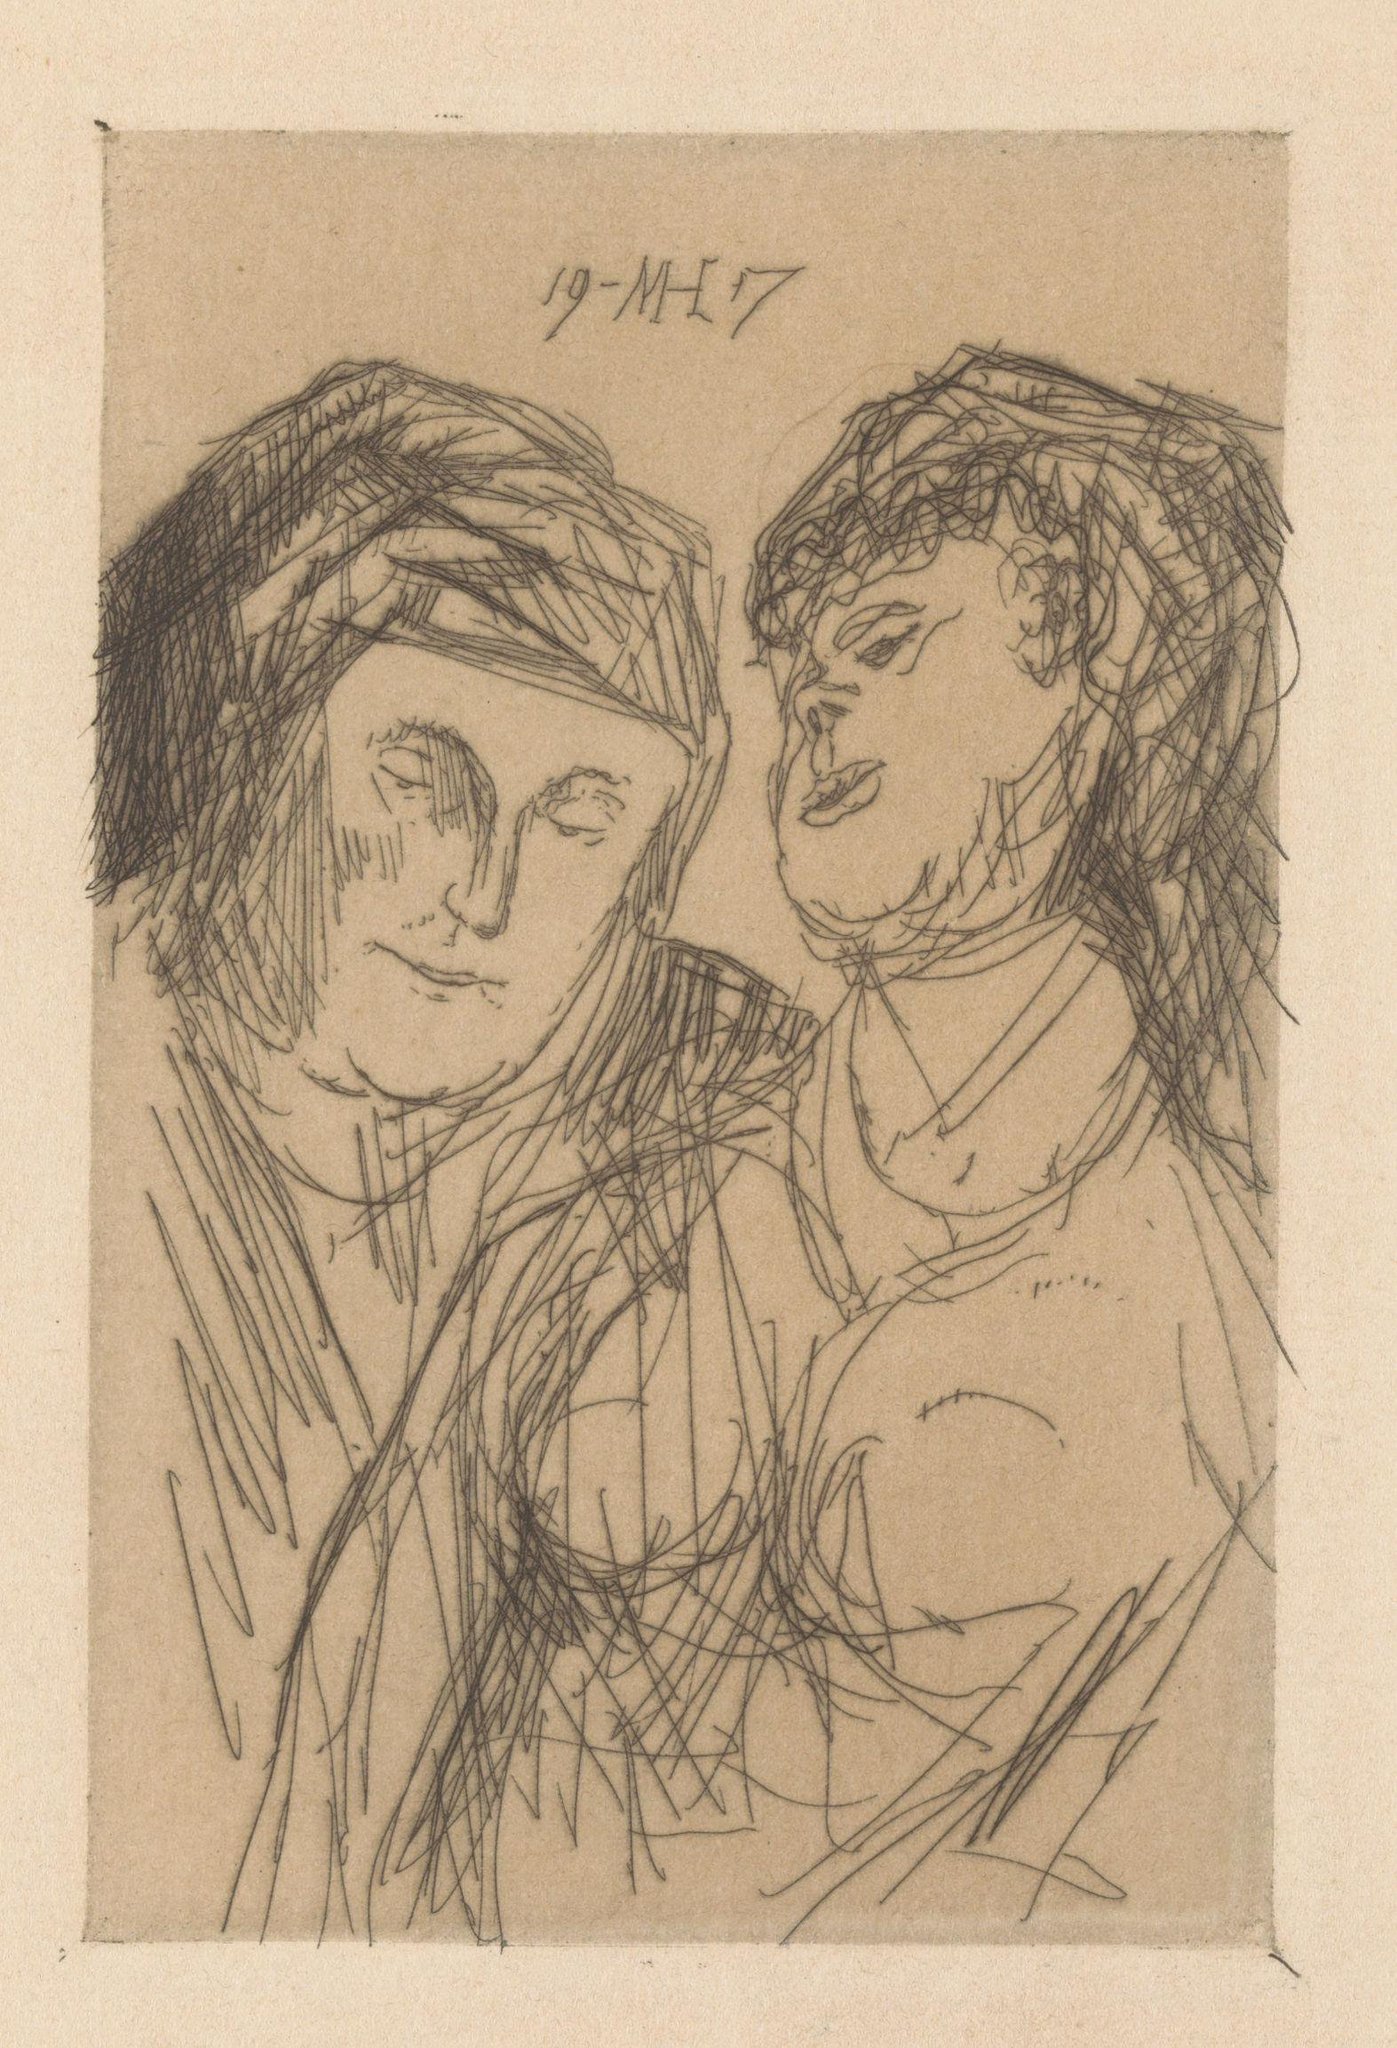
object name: print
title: Jonge vrouw en non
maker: marius holleman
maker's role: draughtsman, print maker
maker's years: 1878-1926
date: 1917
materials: paper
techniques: etching, intaglio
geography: groningen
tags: adolescent, young woman, maiden, nun(s)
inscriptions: collector's mark: Lugt 2228